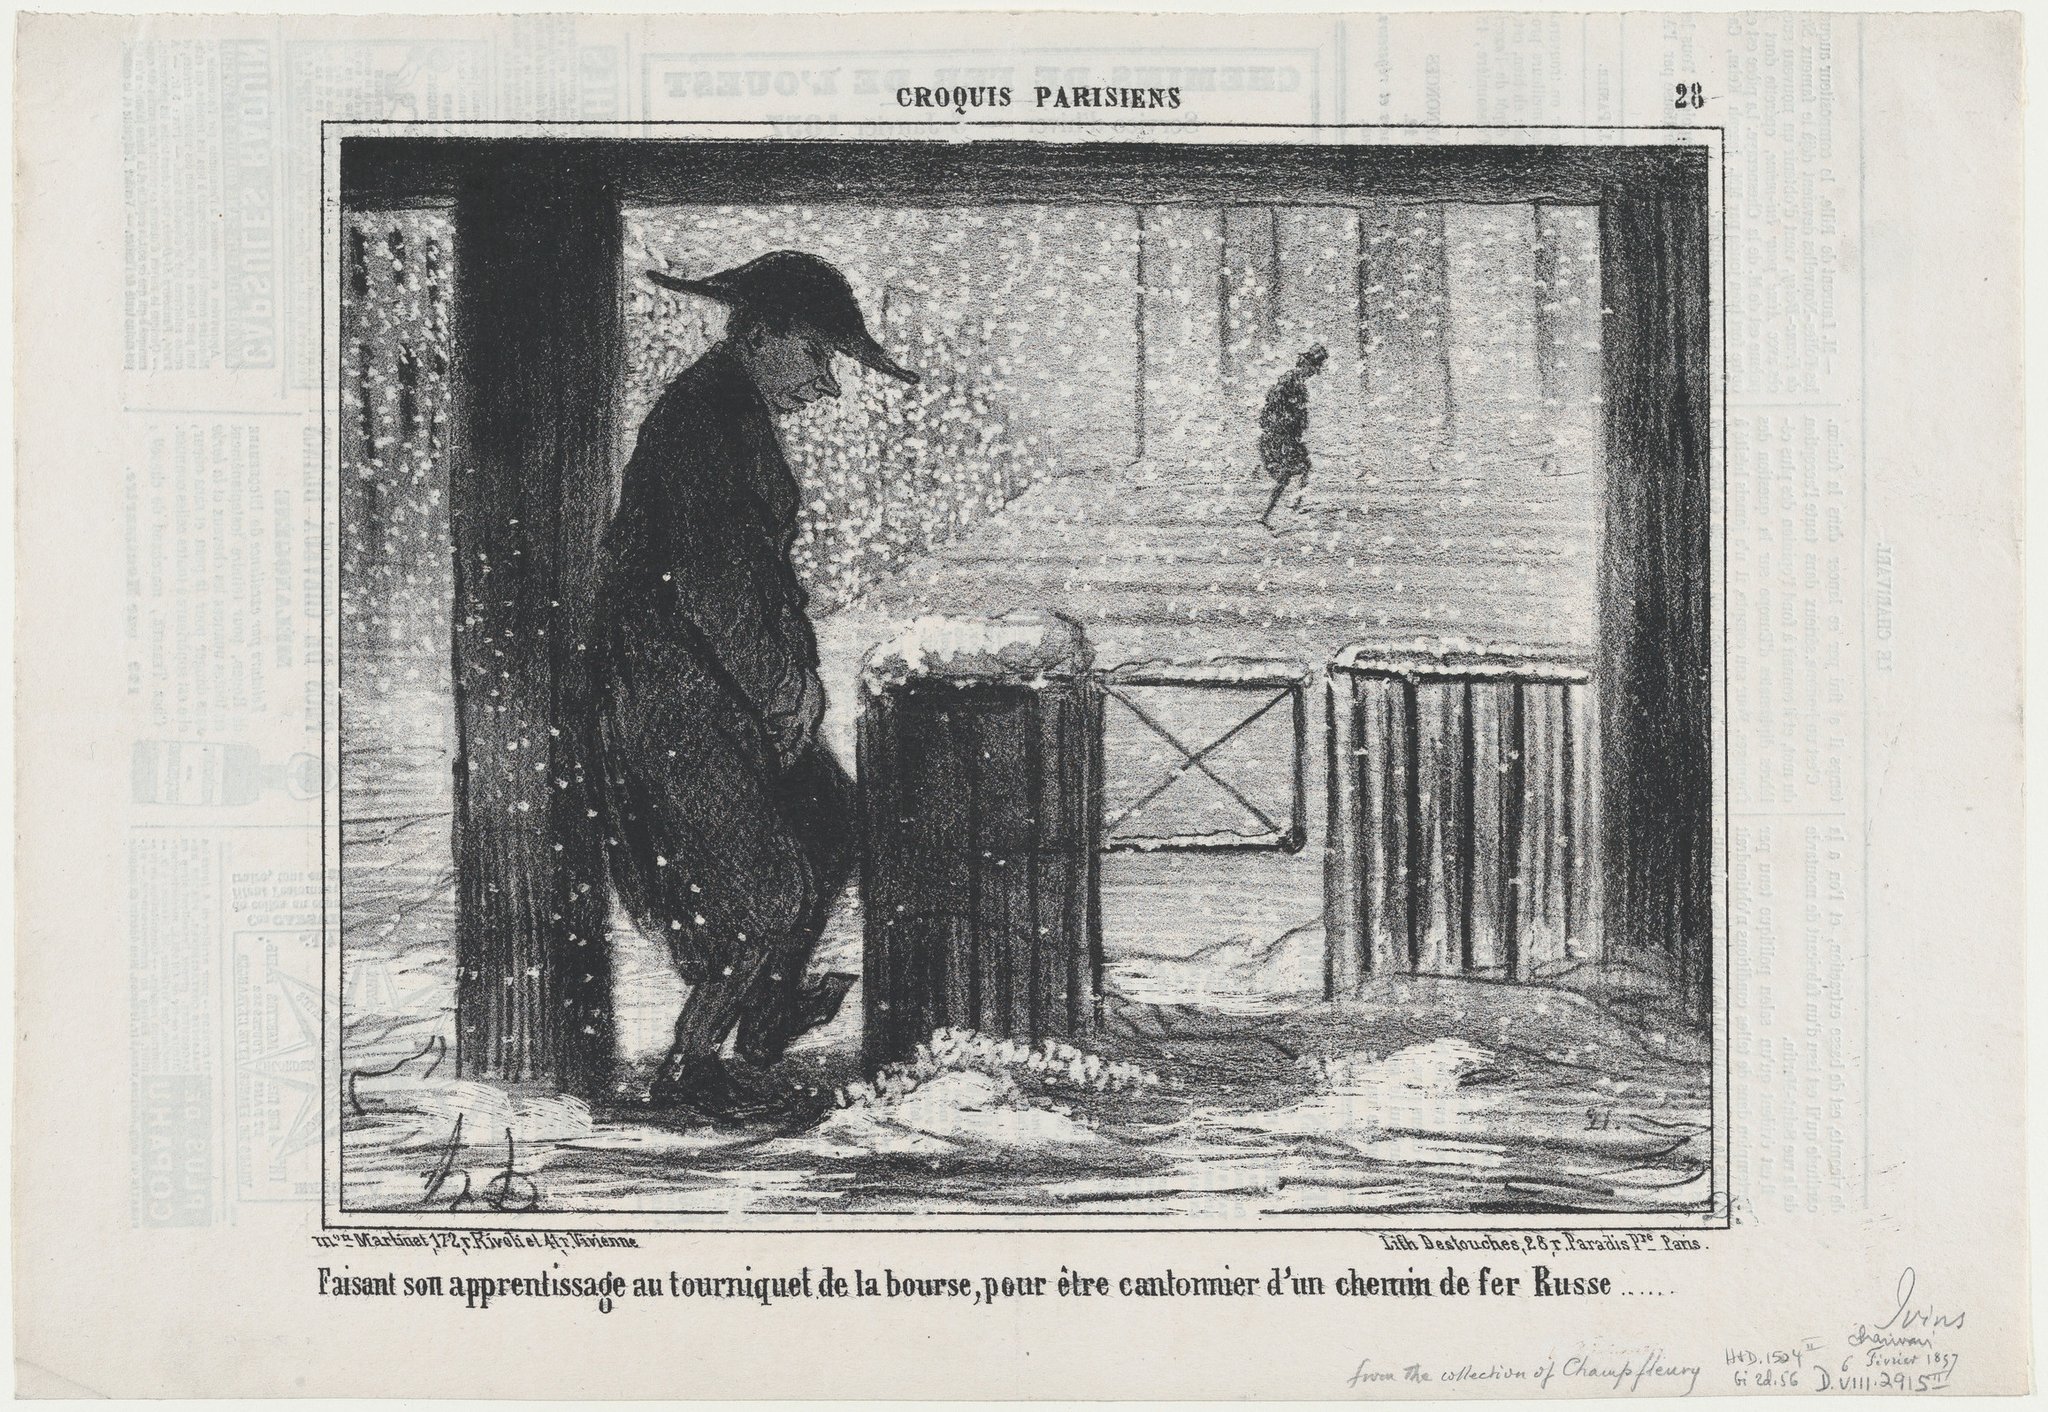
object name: print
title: Faisant son apprentissage au tourniquet de la bourse..., from Croquis Parisiens, published in Le Charivari, February 6, 1857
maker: honoré daumier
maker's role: artist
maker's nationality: french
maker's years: 1808-1879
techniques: lithograph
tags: gates,men,snow